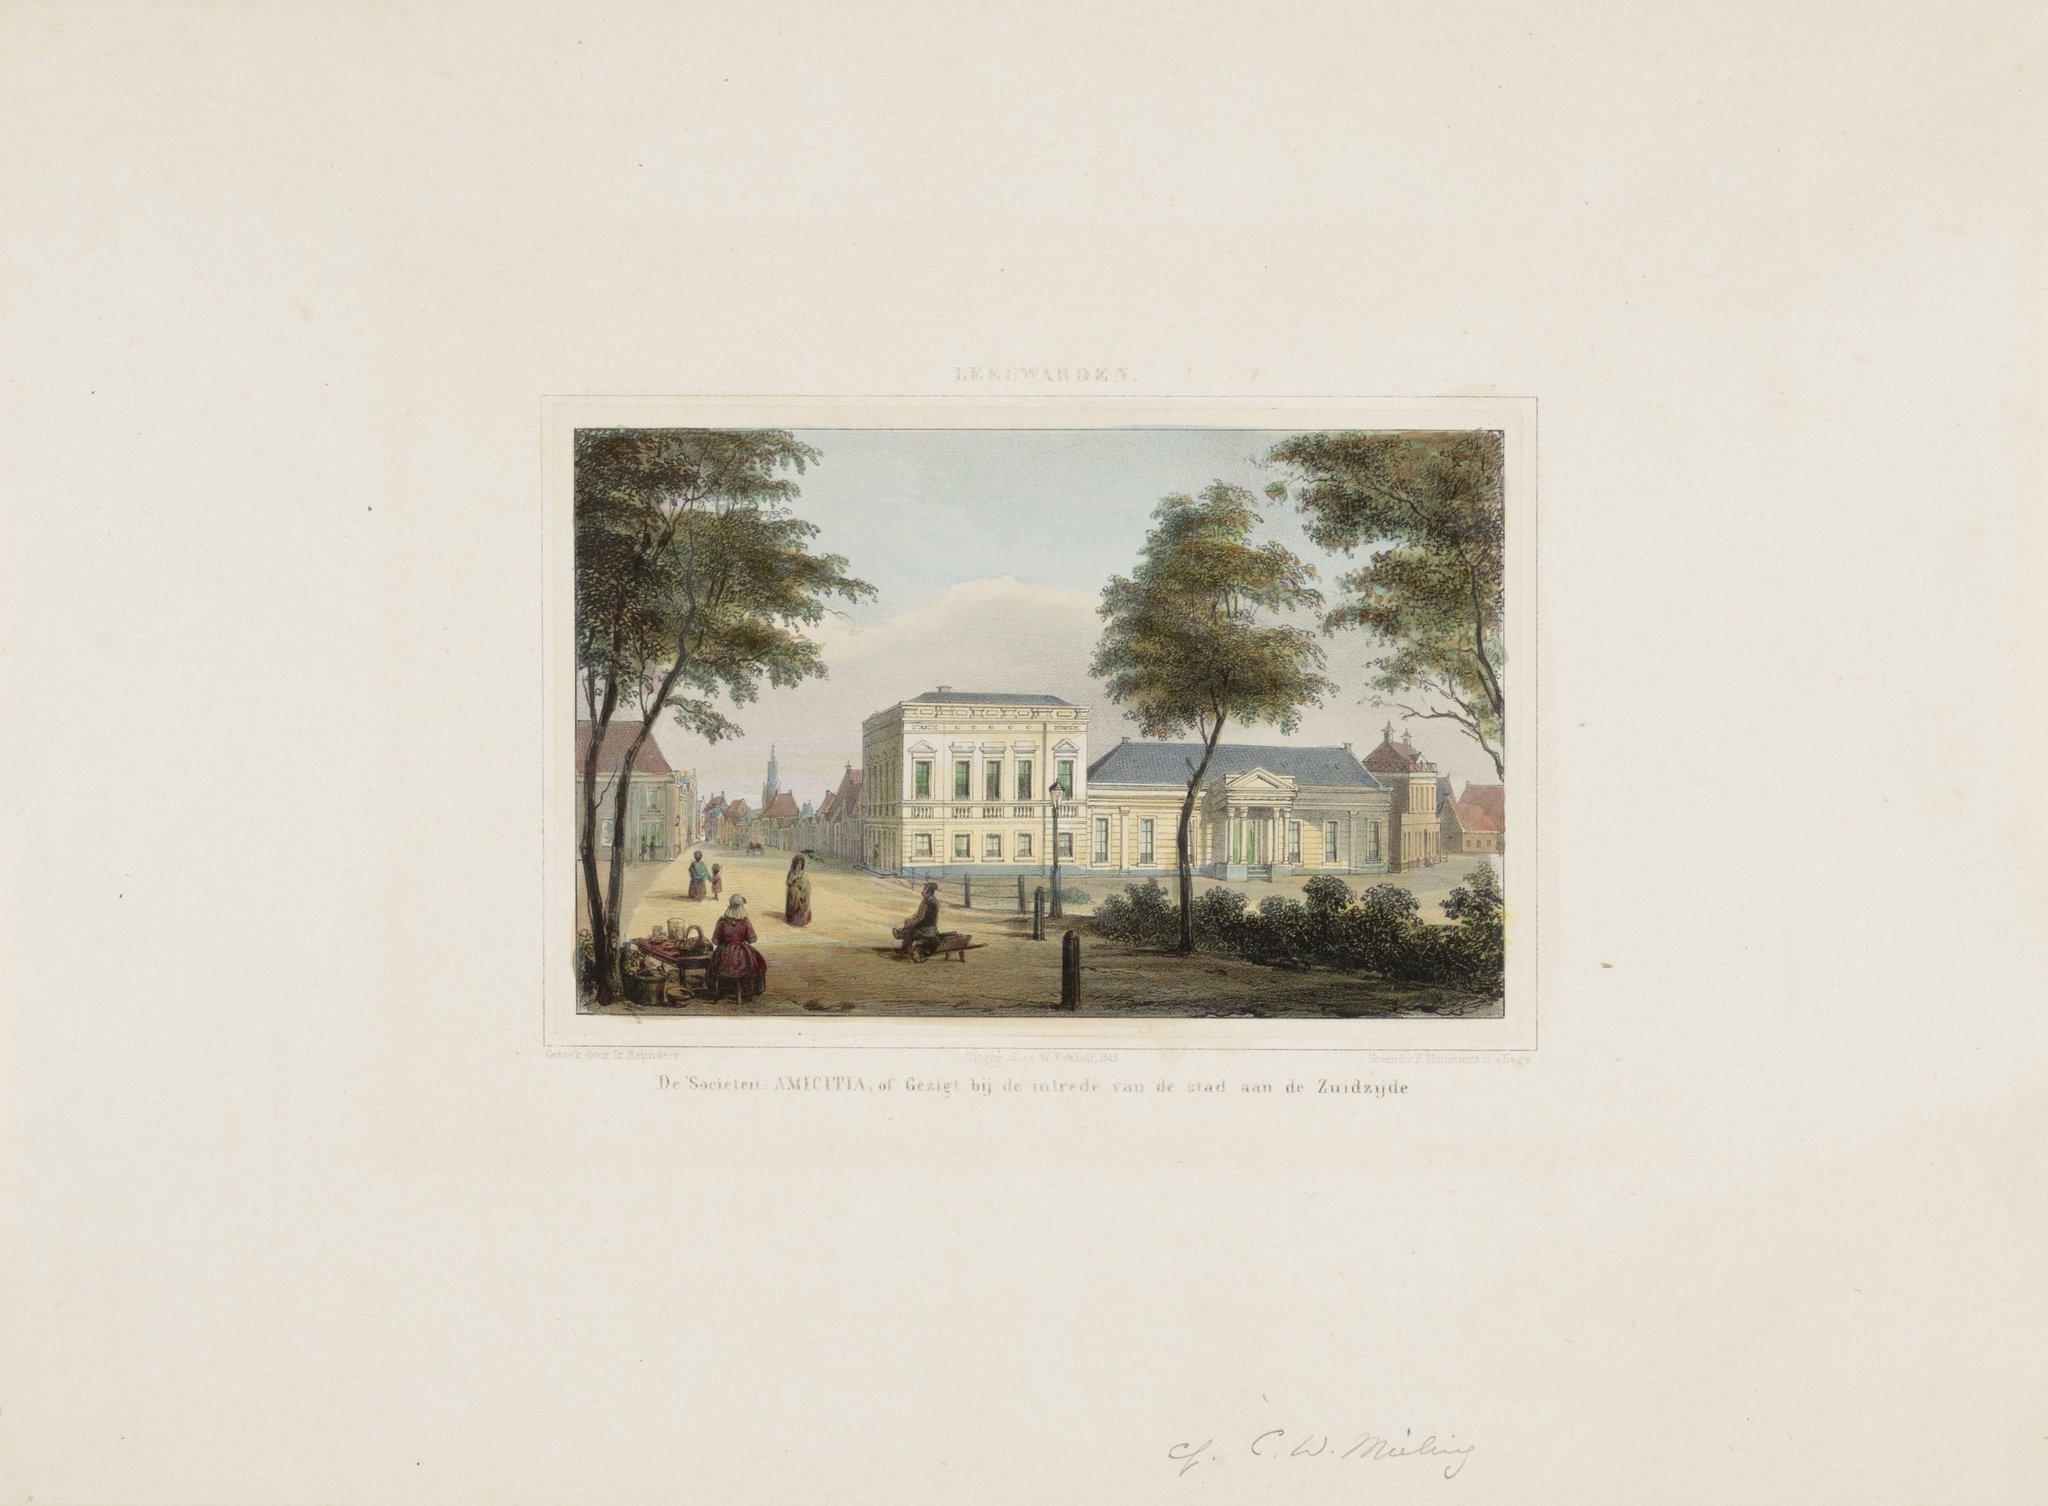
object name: print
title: Gezicht op sociëteit Amicitia in Leeuwarden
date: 1849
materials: paper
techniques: hand coloring, lithograph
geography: netherlands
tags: parts of church exterior and annexes: campanile, city-view, and landscape with man-made constructions (+ city(-scape) with figures, staffage)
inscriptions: inscription: ‘af. C. W. Mieling’, collector's mark: Lugt 2228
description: Blik op de Wirdumerdijk vanuit het zuiden. Rechts de sociëteit en op de achtergrond de Nieuwe Toren.